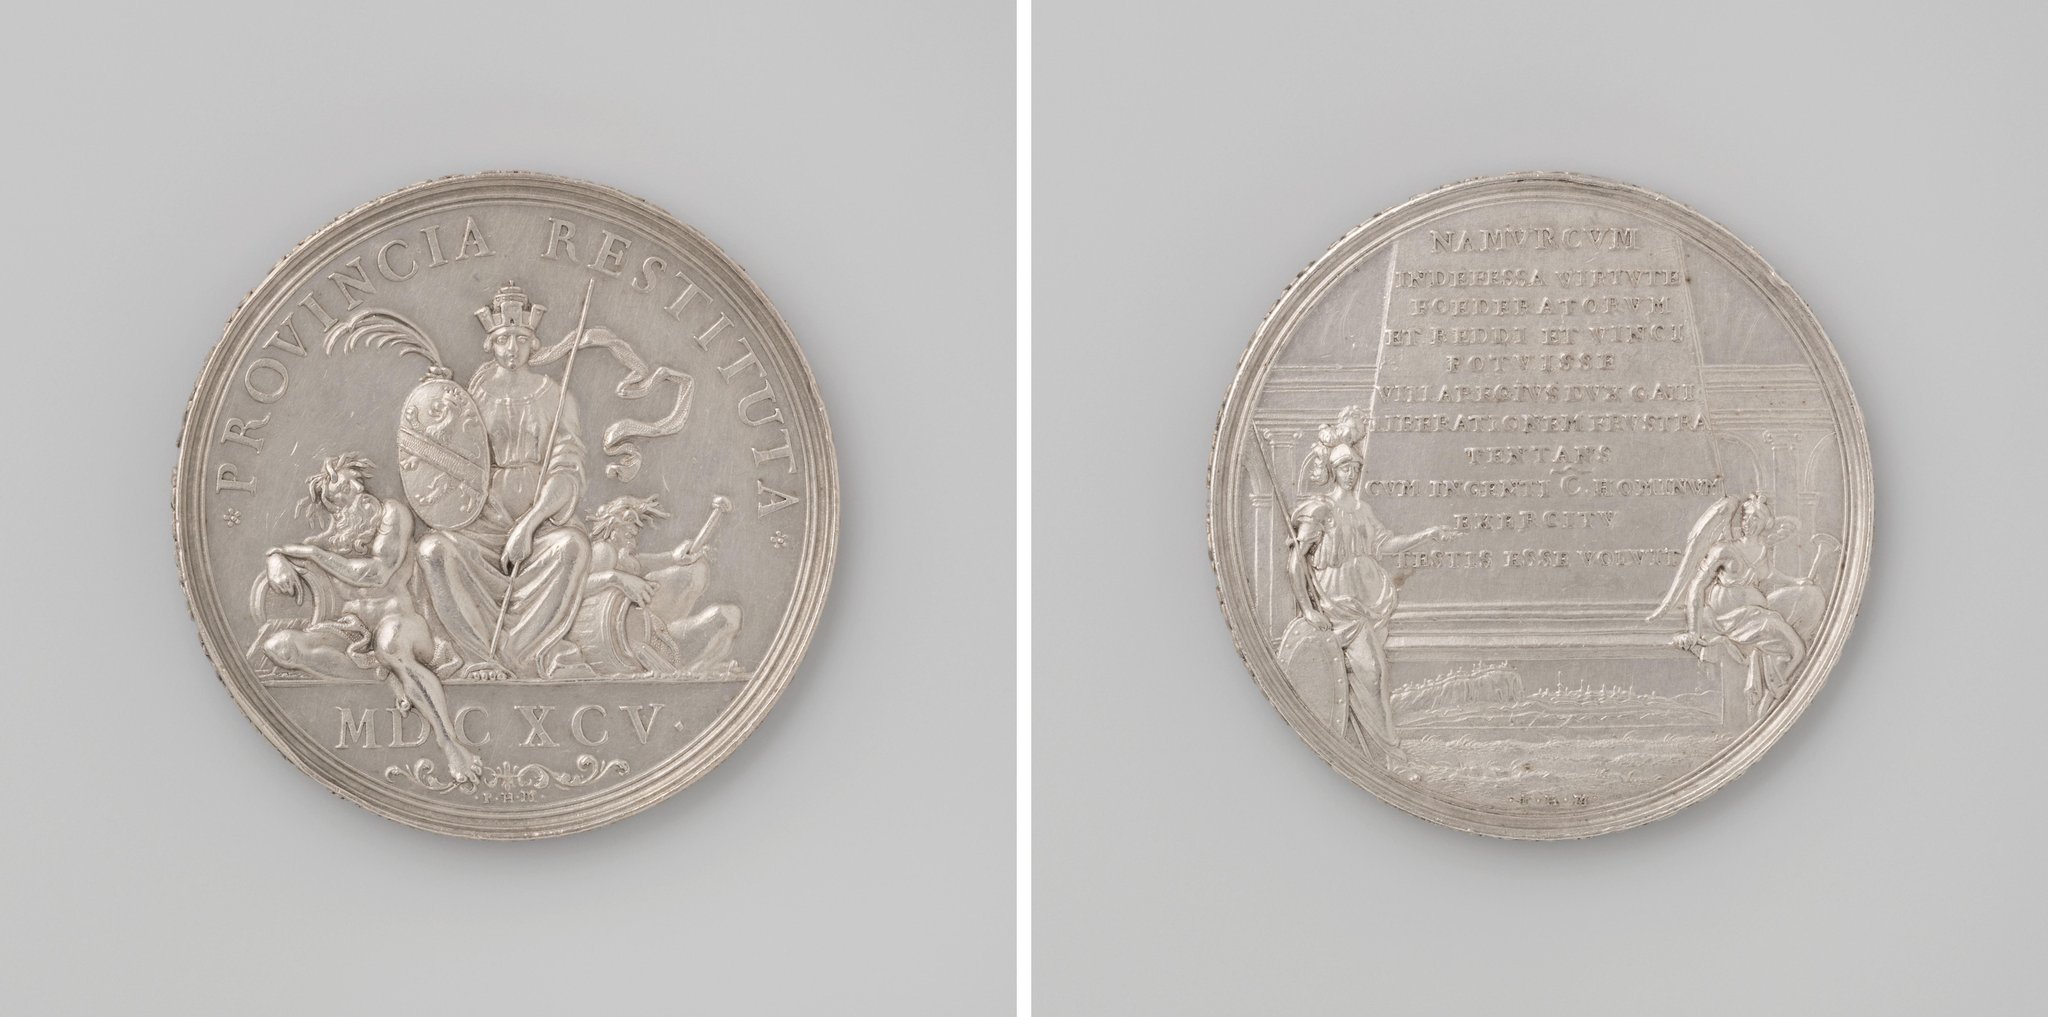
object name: history medal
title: Herovering van Namen door Willem III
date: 1695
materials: silver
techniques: striking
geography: nuremberg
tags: the hague, william iii (prince of orange and king of england, scotland, and ireland)